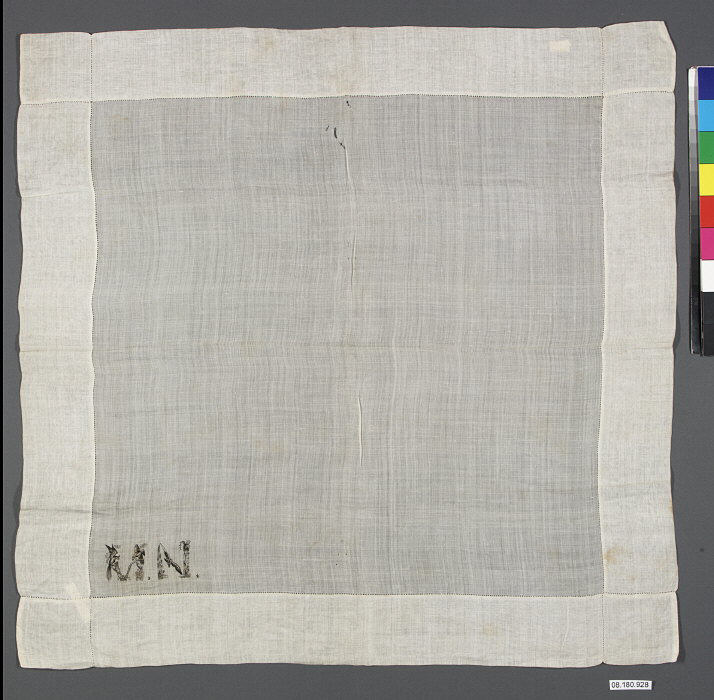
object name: handkerchief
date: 1801-1900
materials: hair, silk